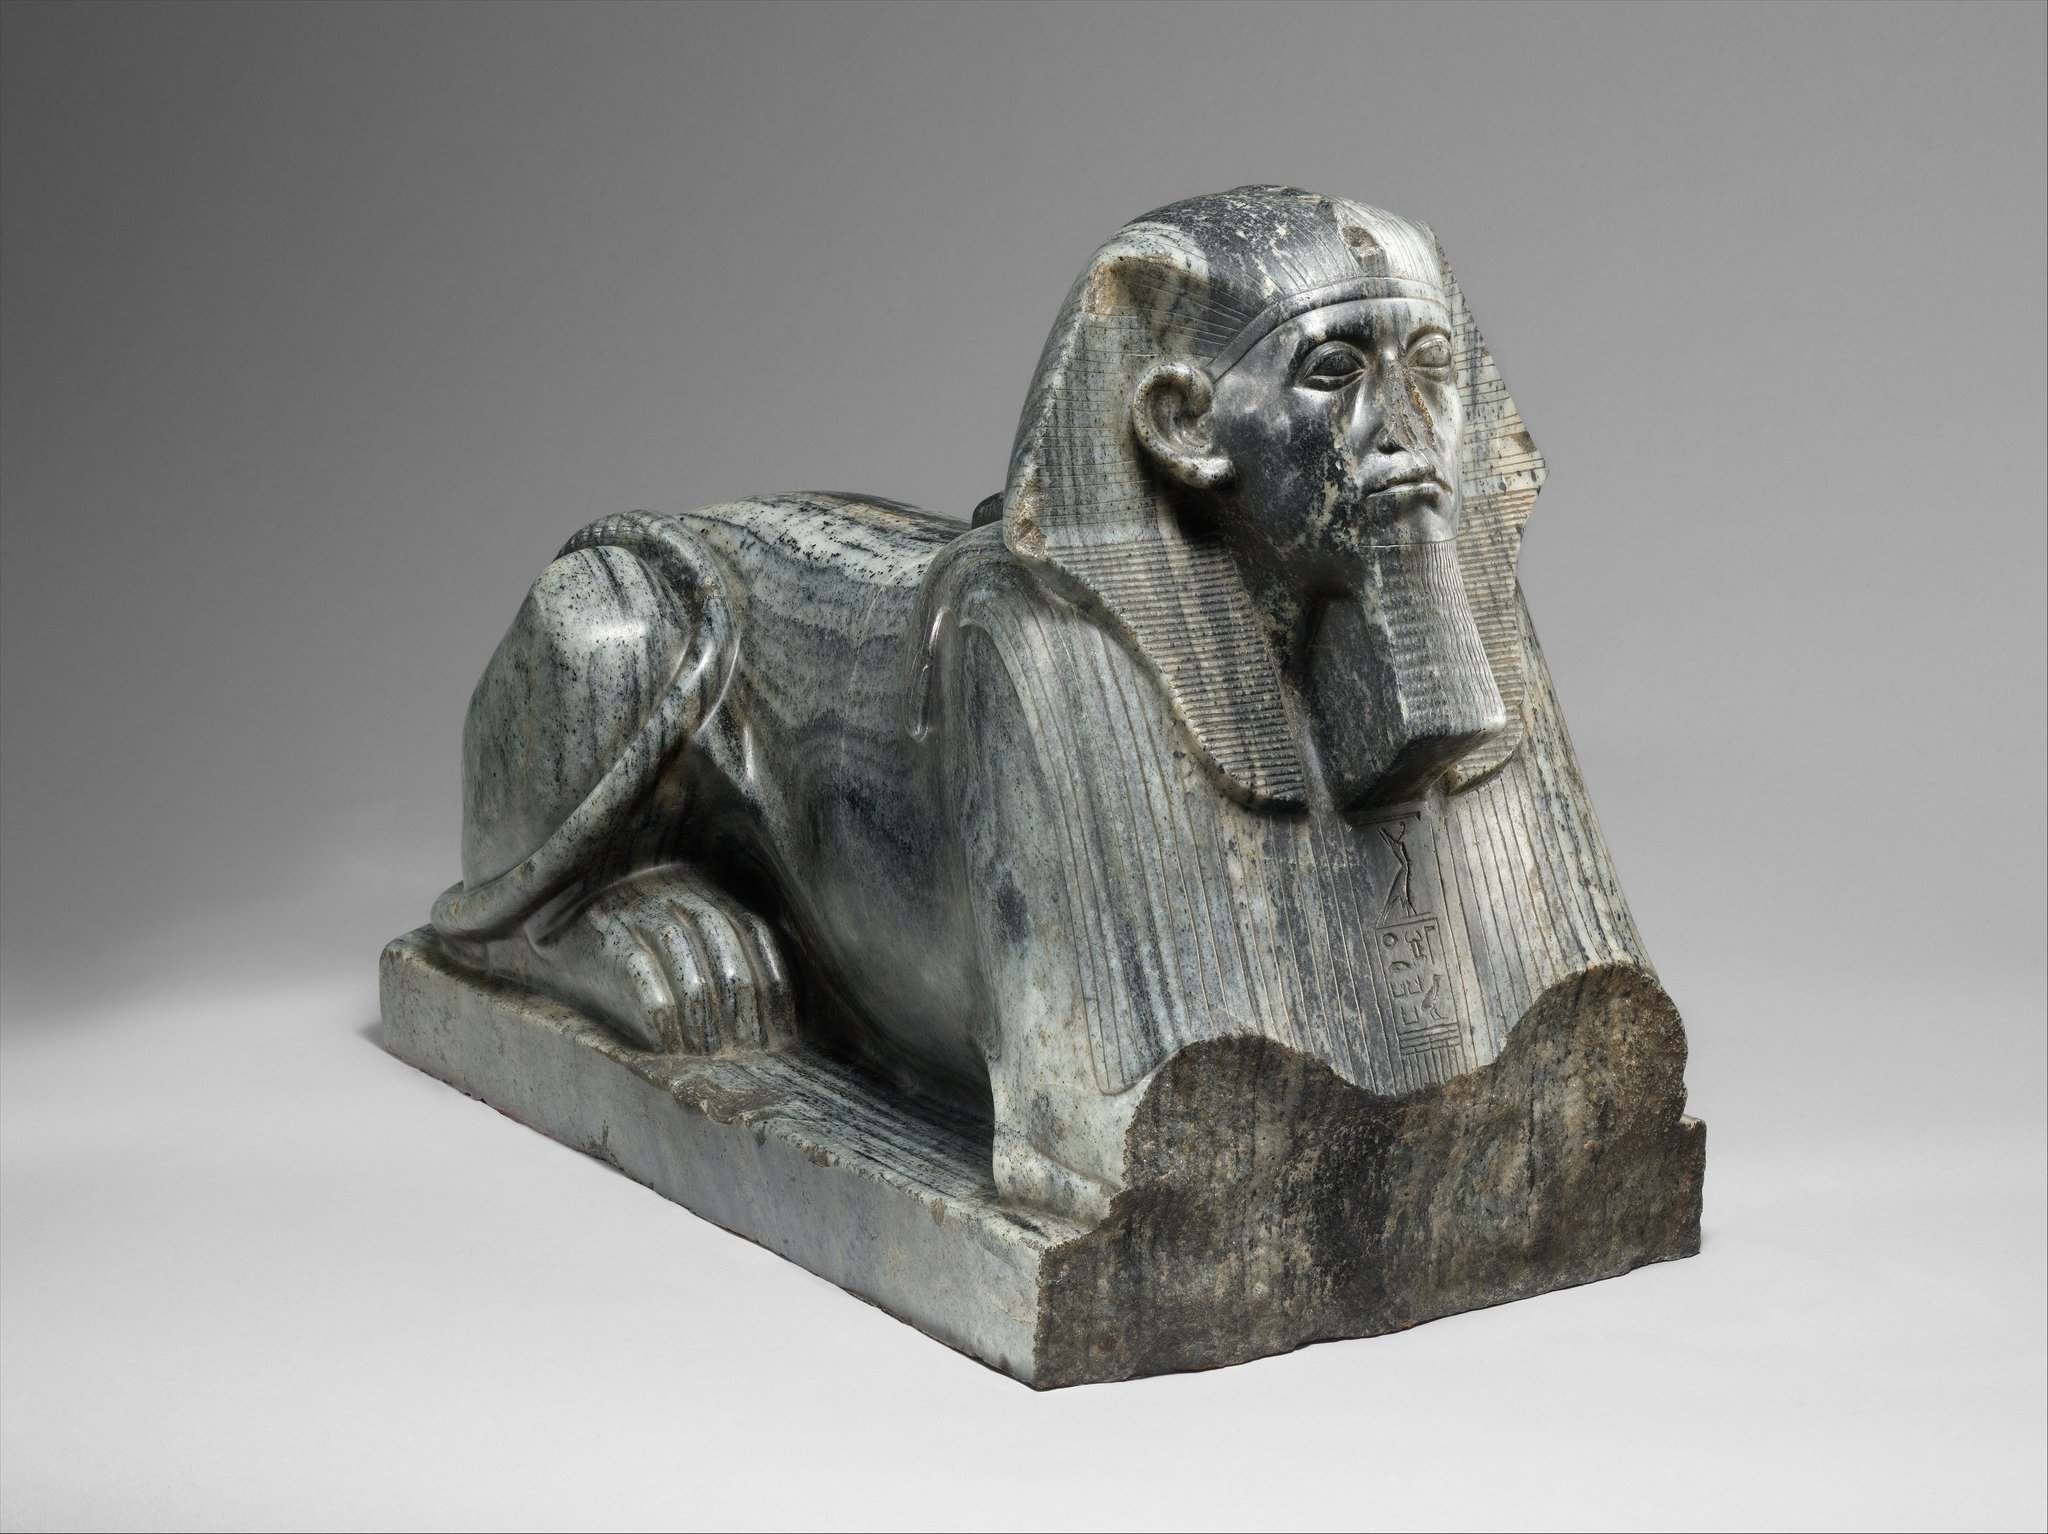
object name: sphinx, senwosret iii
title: Senwosret III as a Sphinx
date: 1878-1840 BCE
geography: upper egypt, thebes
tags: hieroglyphs,sphinx,mk-kings